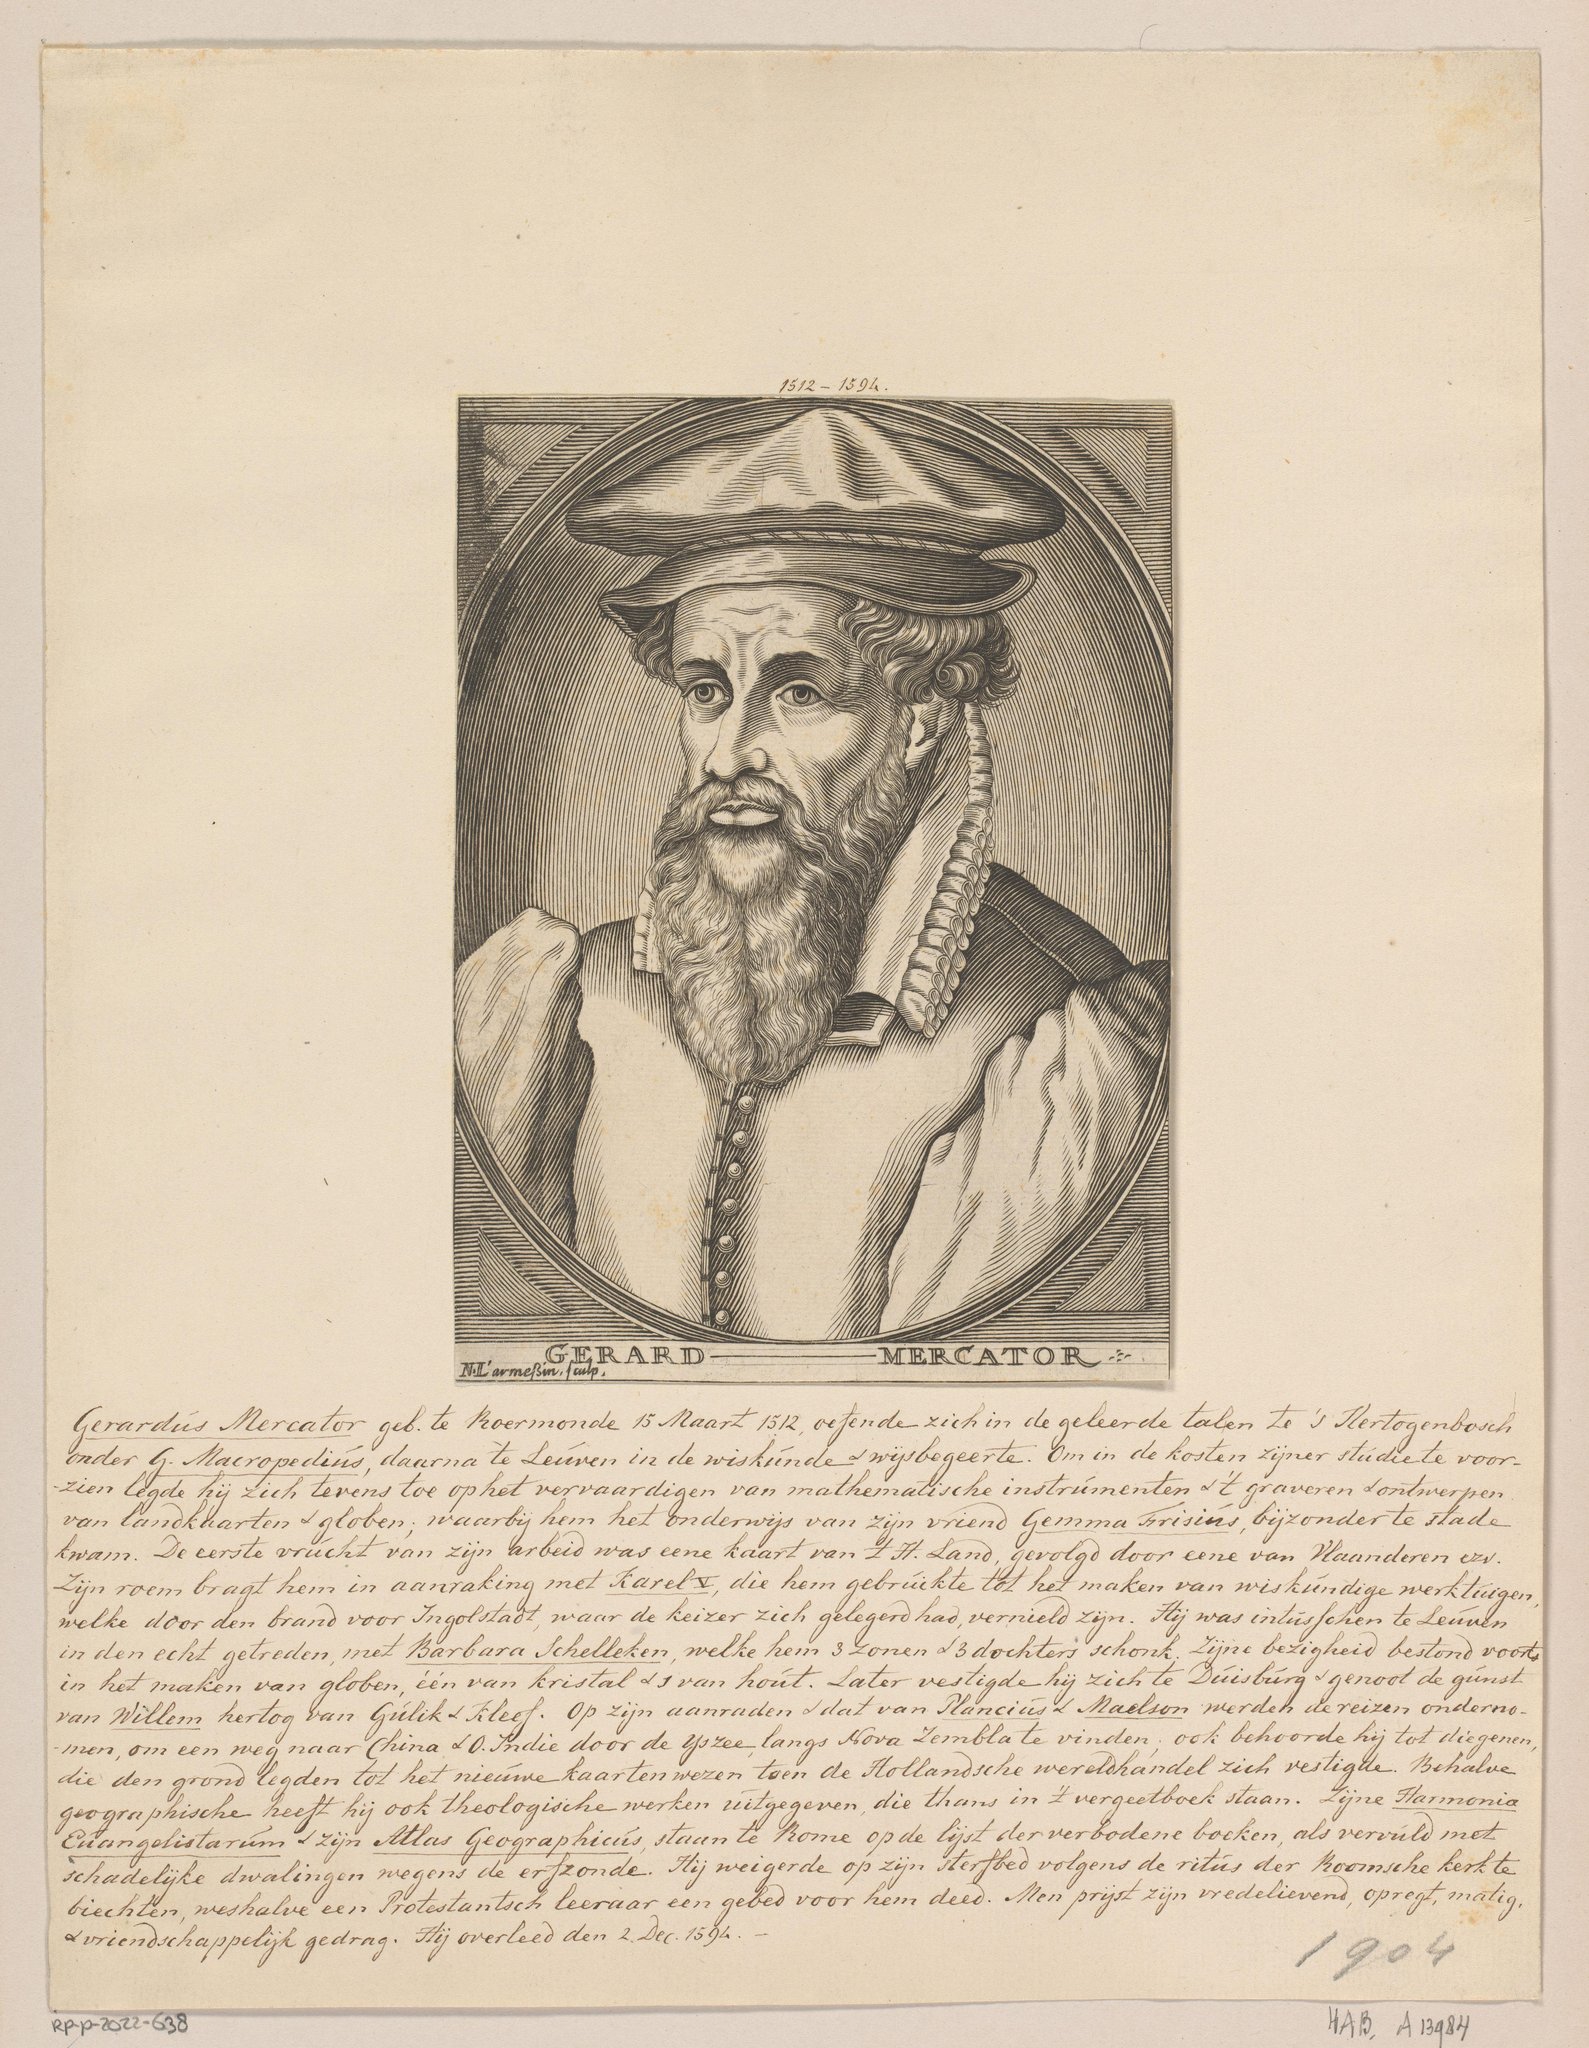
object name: print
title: Portret van Gerardus Mercator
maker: nicolas de larmessin (i)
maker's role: print maker, publisher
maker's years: 1632-1694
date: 1682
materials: paper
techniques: engraving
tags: instrument maker, gerardus mercator, historical persons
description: Prent waarschijnlijk uit: Bullart, Isaac. Académie des Sciences et Arts contenant les vies et éloges his. des hommes illustres qui ont excellé en ces professions depuis environ quatre siècles. Brussel: François Foppens, 1682, dl. 2, p. 285.